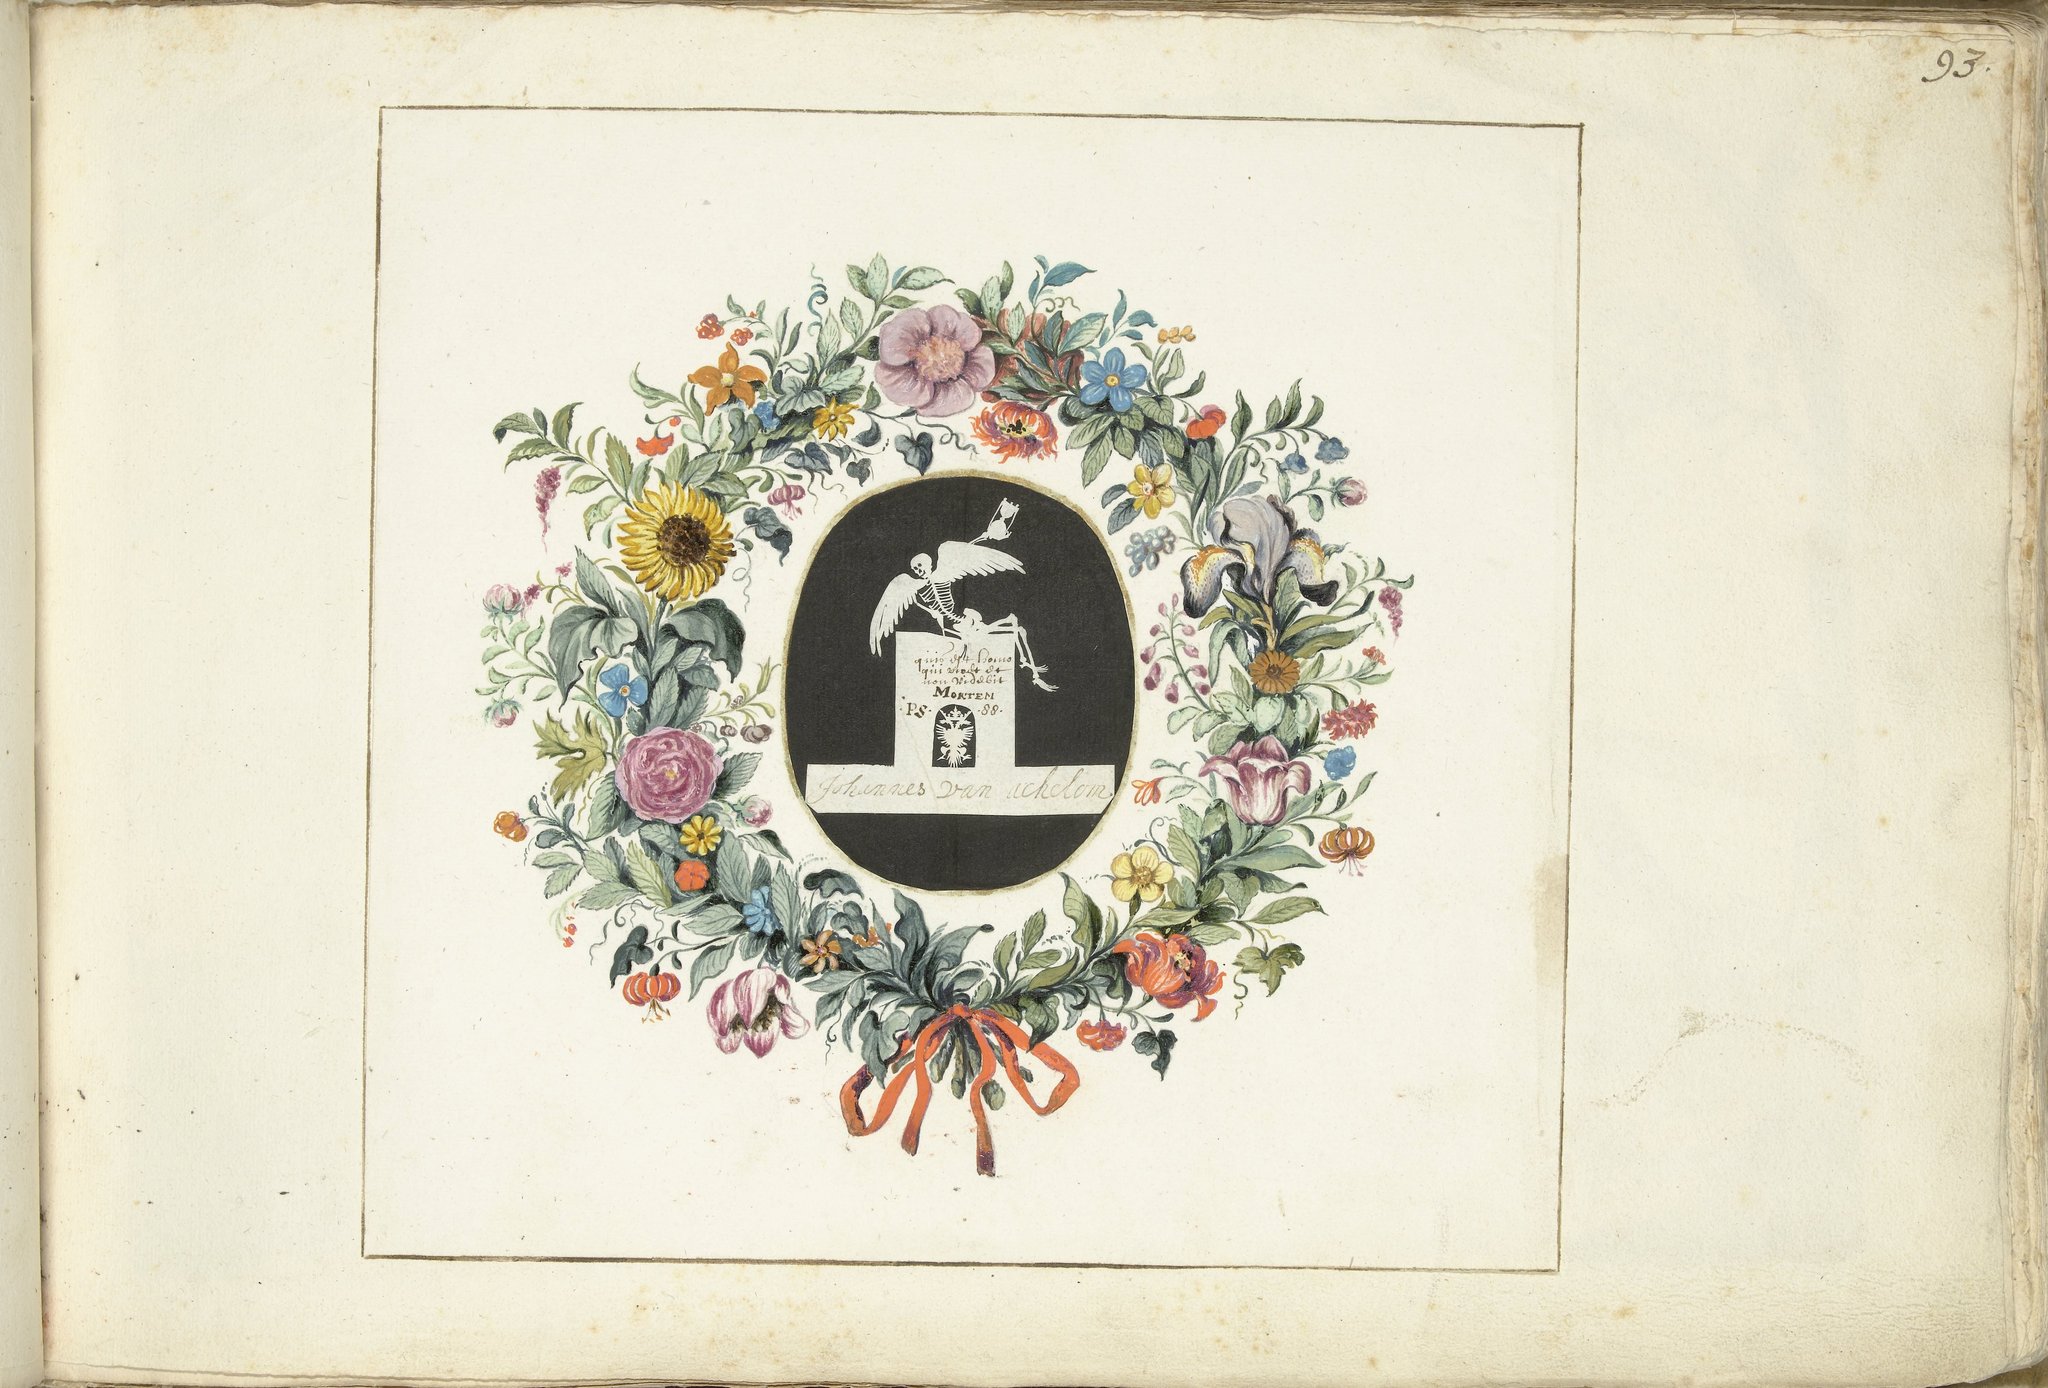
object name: watercolor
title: Bloemguirlande om een knipsel van een grafmonument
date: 1670-1687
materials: paper, watercolor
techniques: brush, snipping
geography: amsterdam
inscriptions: annotation: ‘Johannes van Achelom’, inscription: ‘Quis et homo / qui vivet et / non videbit / mortem / .PS.88’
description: Guirlande om een knipsel van een grafmonument met daarop een fragment uit Psalm 88:49. Johannes van Achelom was waarschijnlijk een jonge vriend van de Schellinger-kinderen.